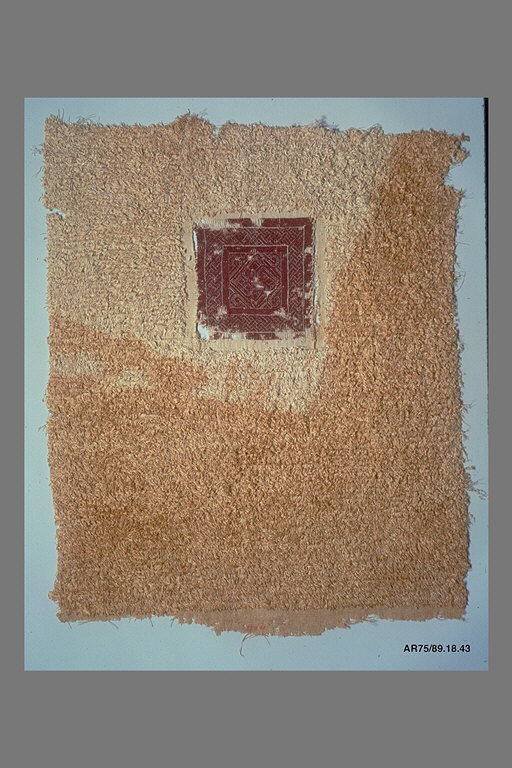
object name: textile fragment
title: Fragment of a Cover or Blanket with Interlace Square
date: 301-500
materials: linen, wool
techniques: weave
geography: egypt